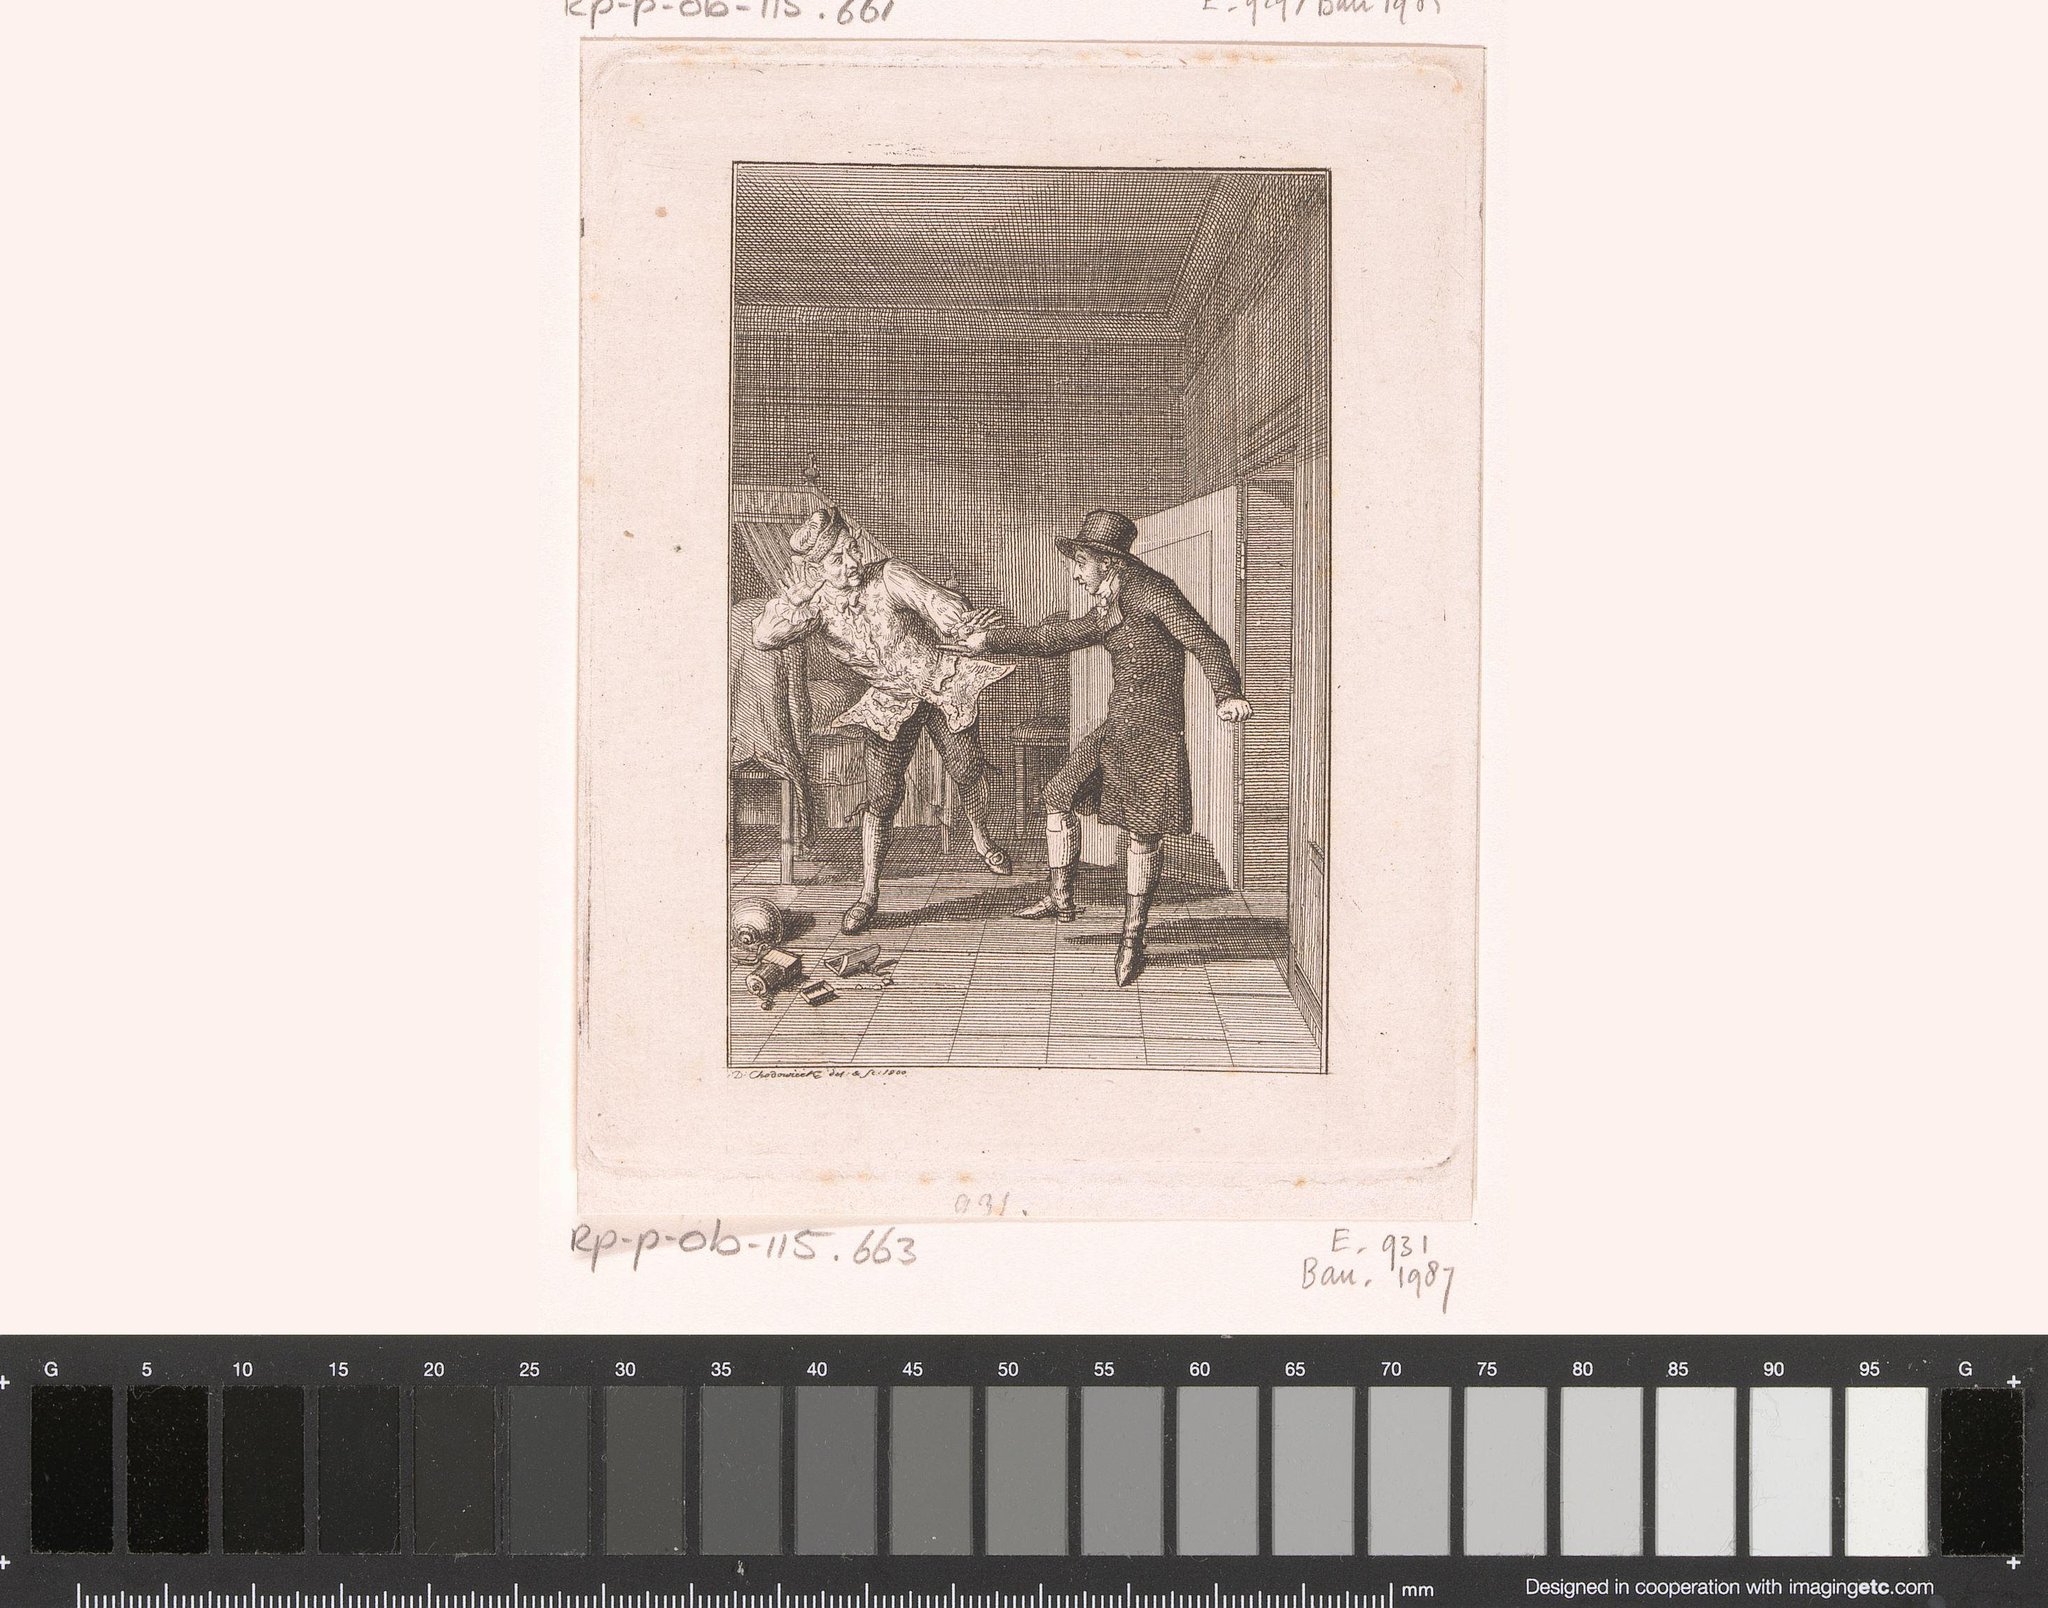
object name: print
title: Castran laat van schrik de koffiemolen vallen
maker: daniel nikolaus chodowiecki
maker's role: draughtsman, print maker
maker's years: 1726-1801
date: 1800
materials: paper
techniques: etching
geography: berlin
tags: coffee-pot, house personnel, servants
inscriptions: collector's mark: Lugt 2228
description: Prent gebruikt voor: Lang, Karl. Taschenbuch für Häusliche und gesellschaftliche Freuden. Frankfurt am Main: Philipp Heinrich Guilhaumain, [1800].